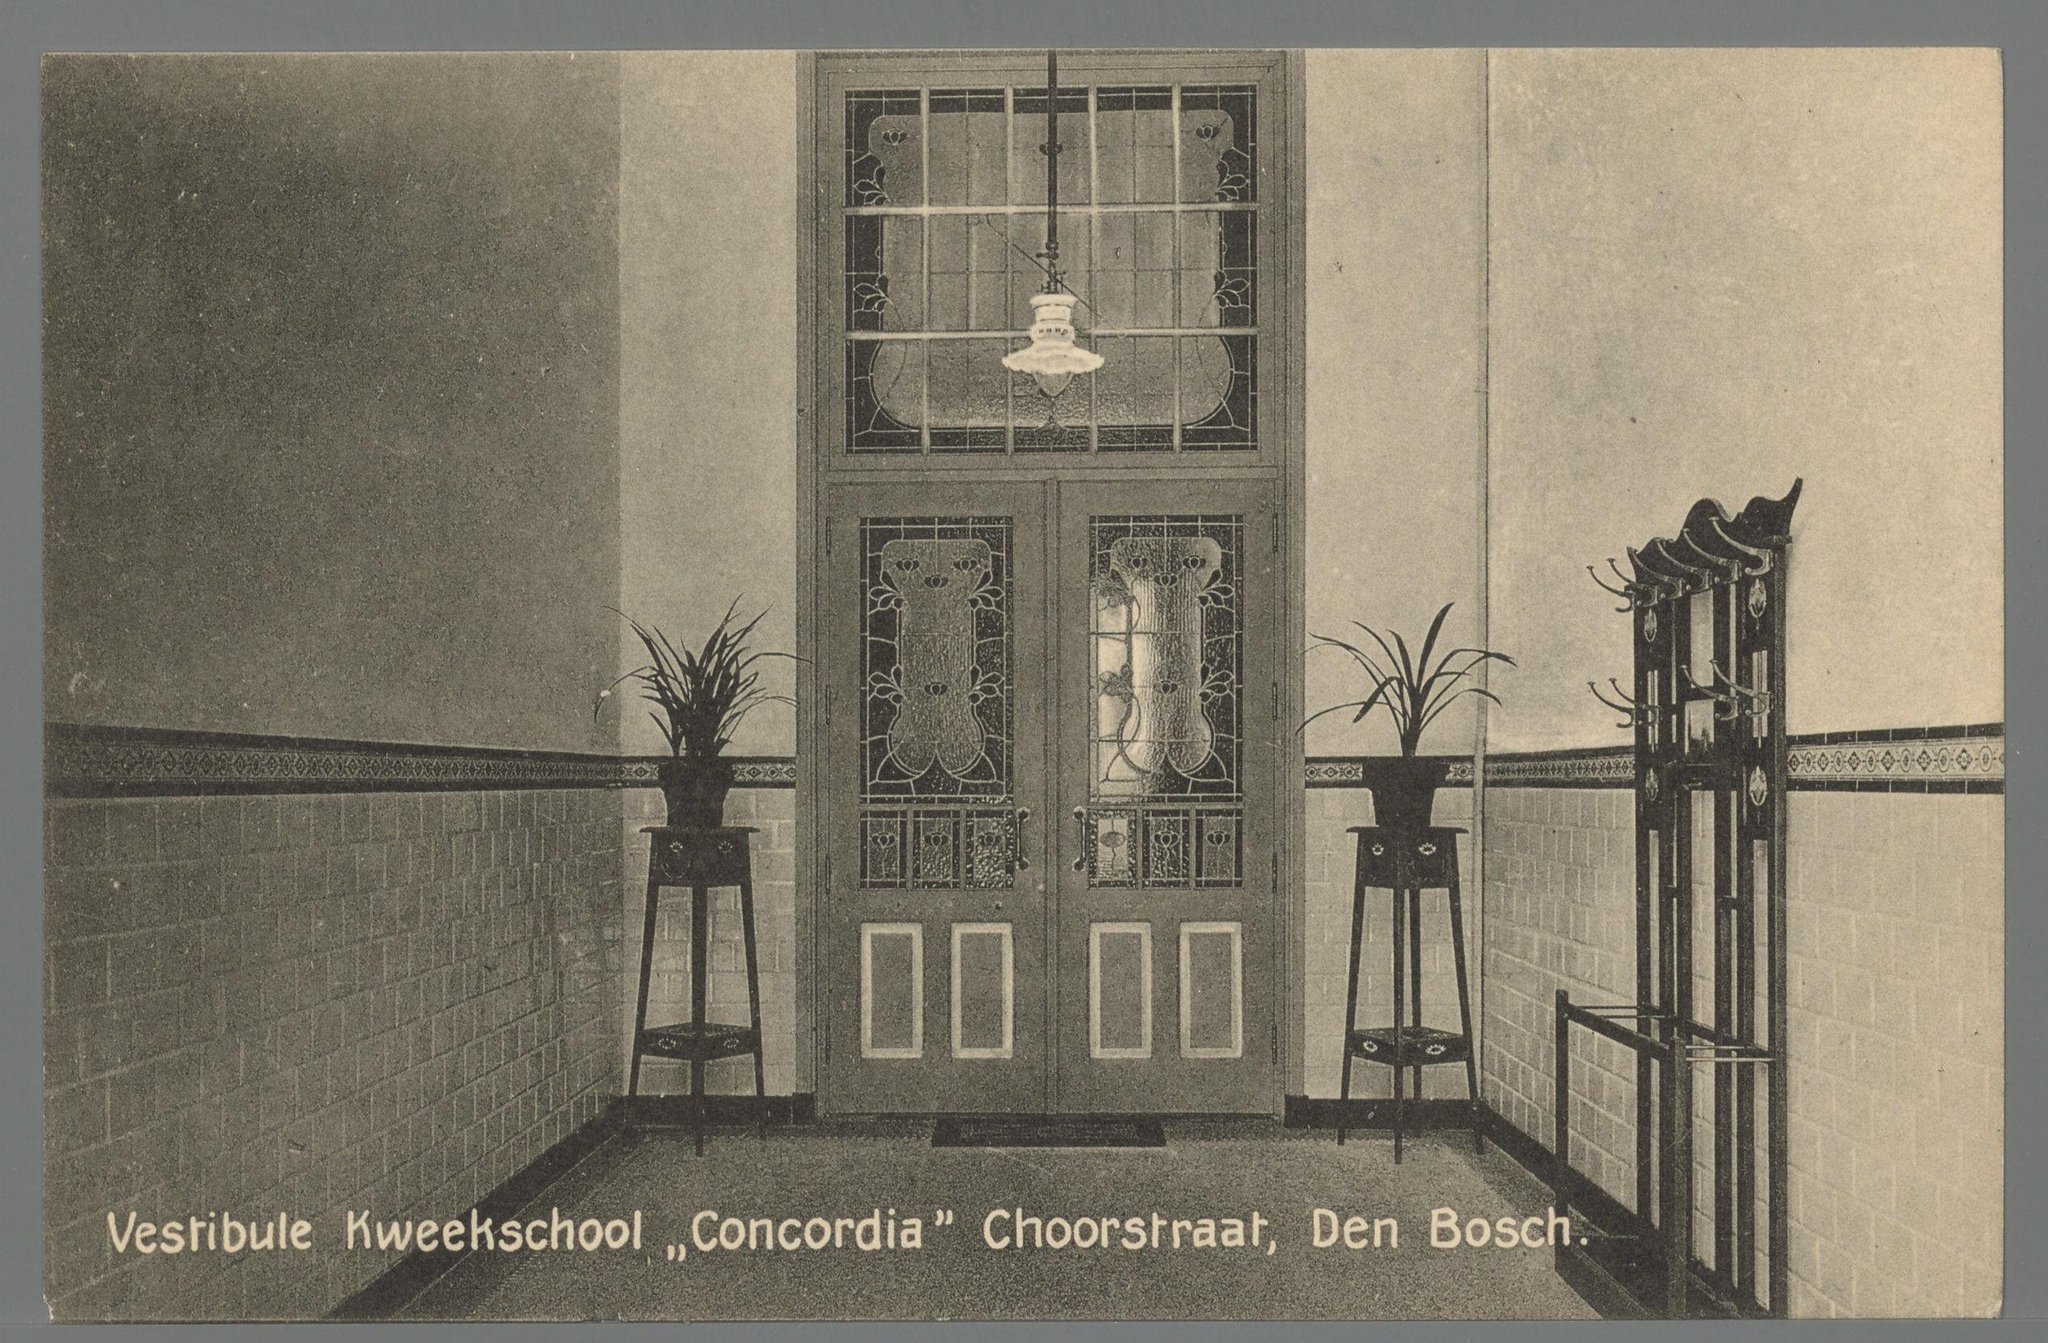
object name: photomechanical print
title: Vestibule Kweekschool "Concordia" Choorstraat, Den Bosch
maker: Anonymous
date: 1908-1930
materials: cardboard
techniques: photograph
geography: rotterdam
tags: vestibule, hall, university building, college, den bosch